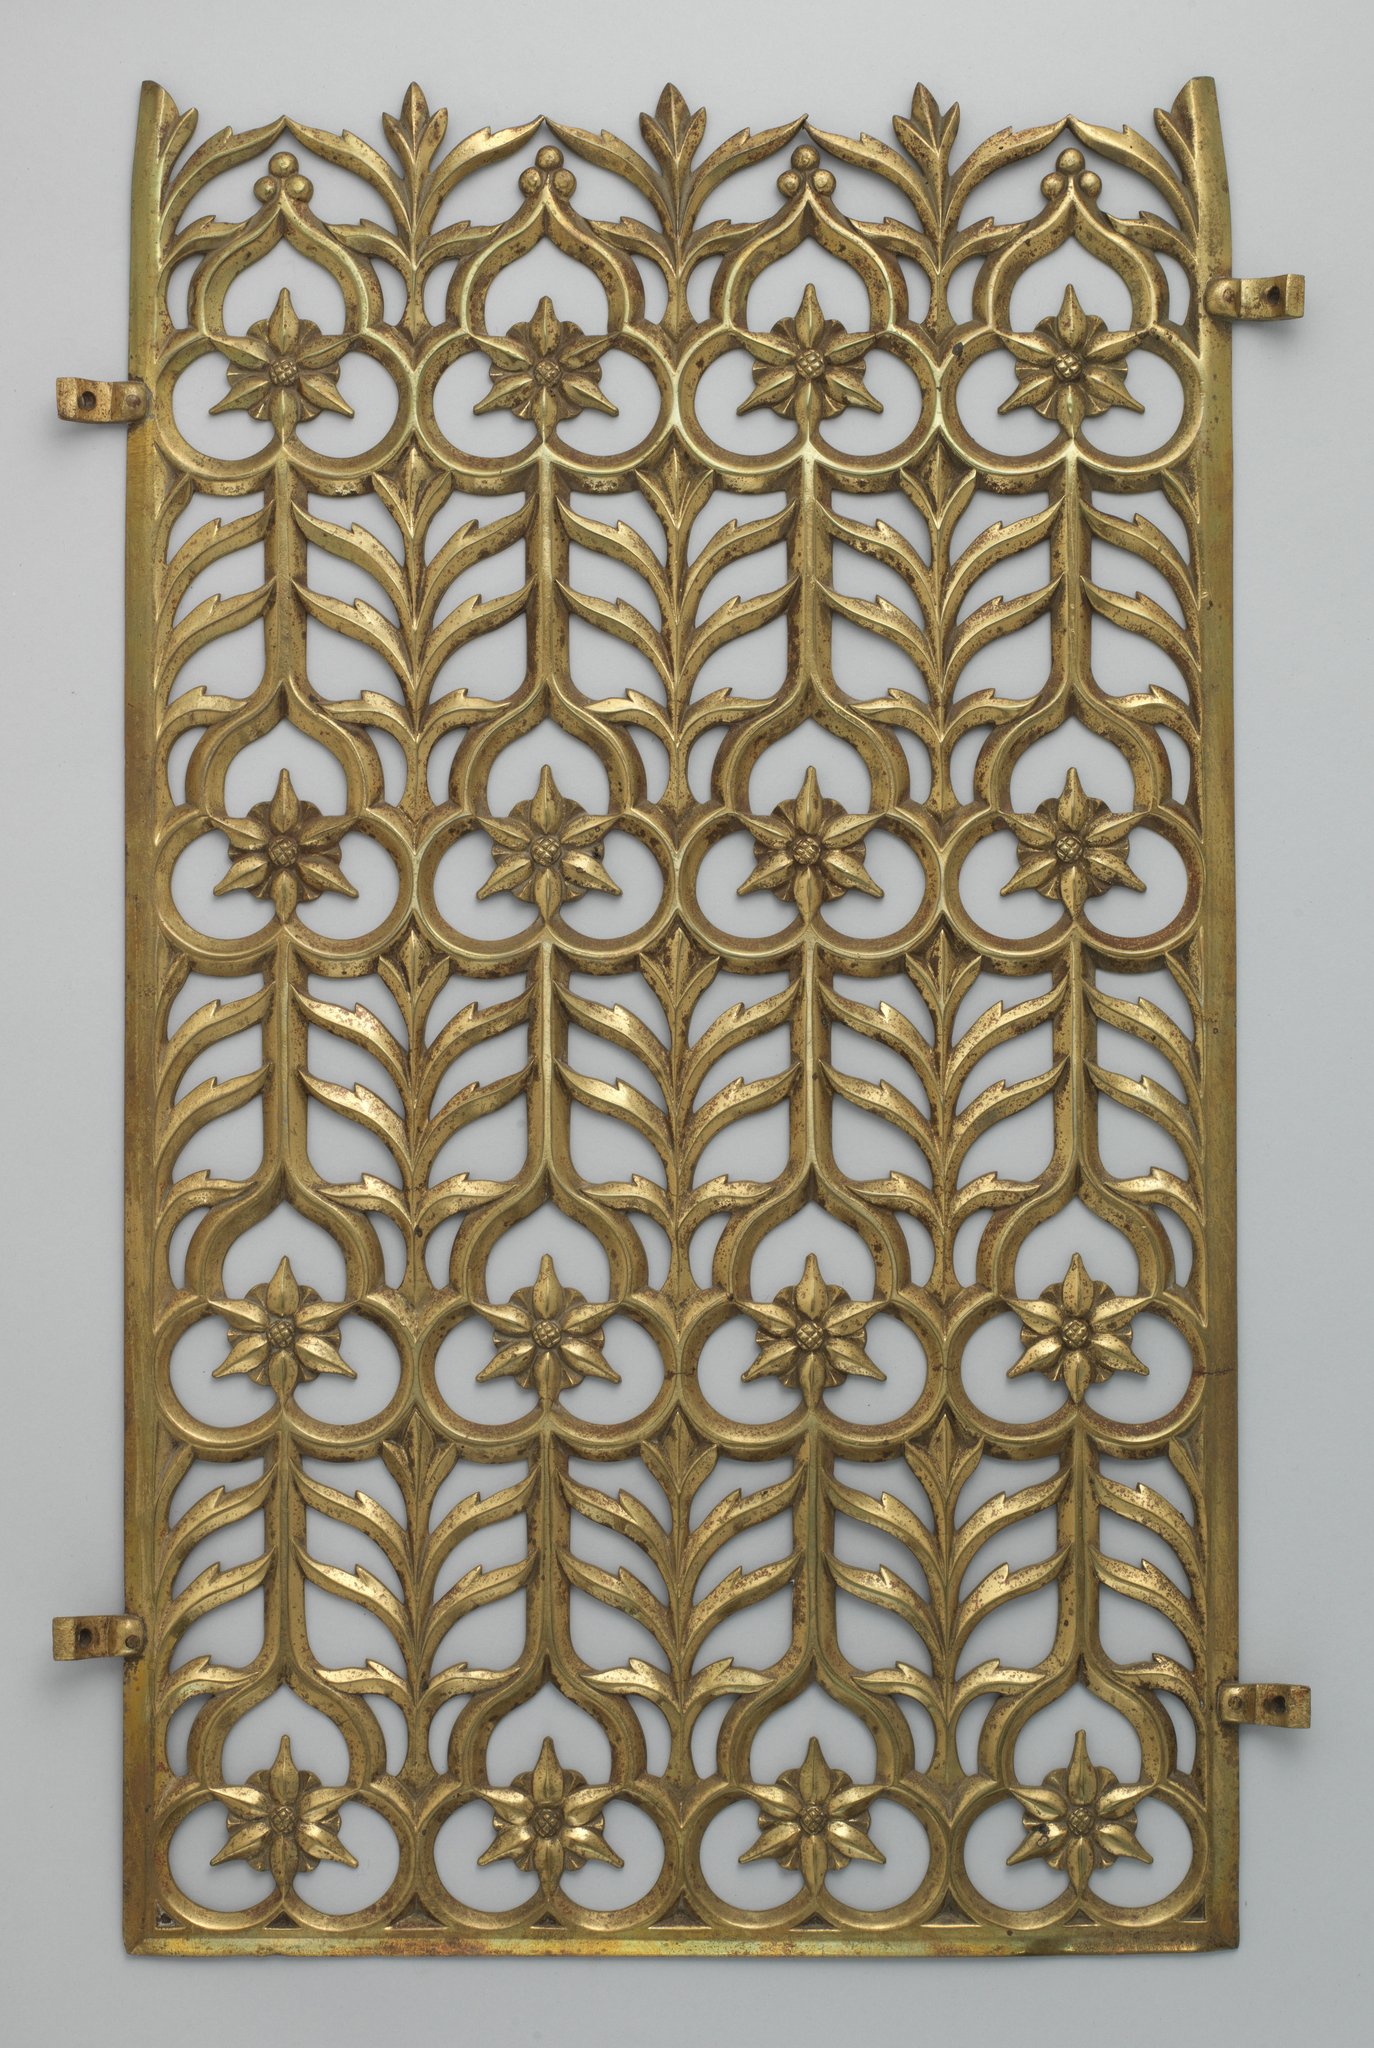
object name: grill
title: Decorative grill from the Palace of Westminster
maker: augustus welby northmore pugin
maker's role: designer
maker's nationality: british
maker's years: 1812-1852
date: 1845-1859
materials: brass